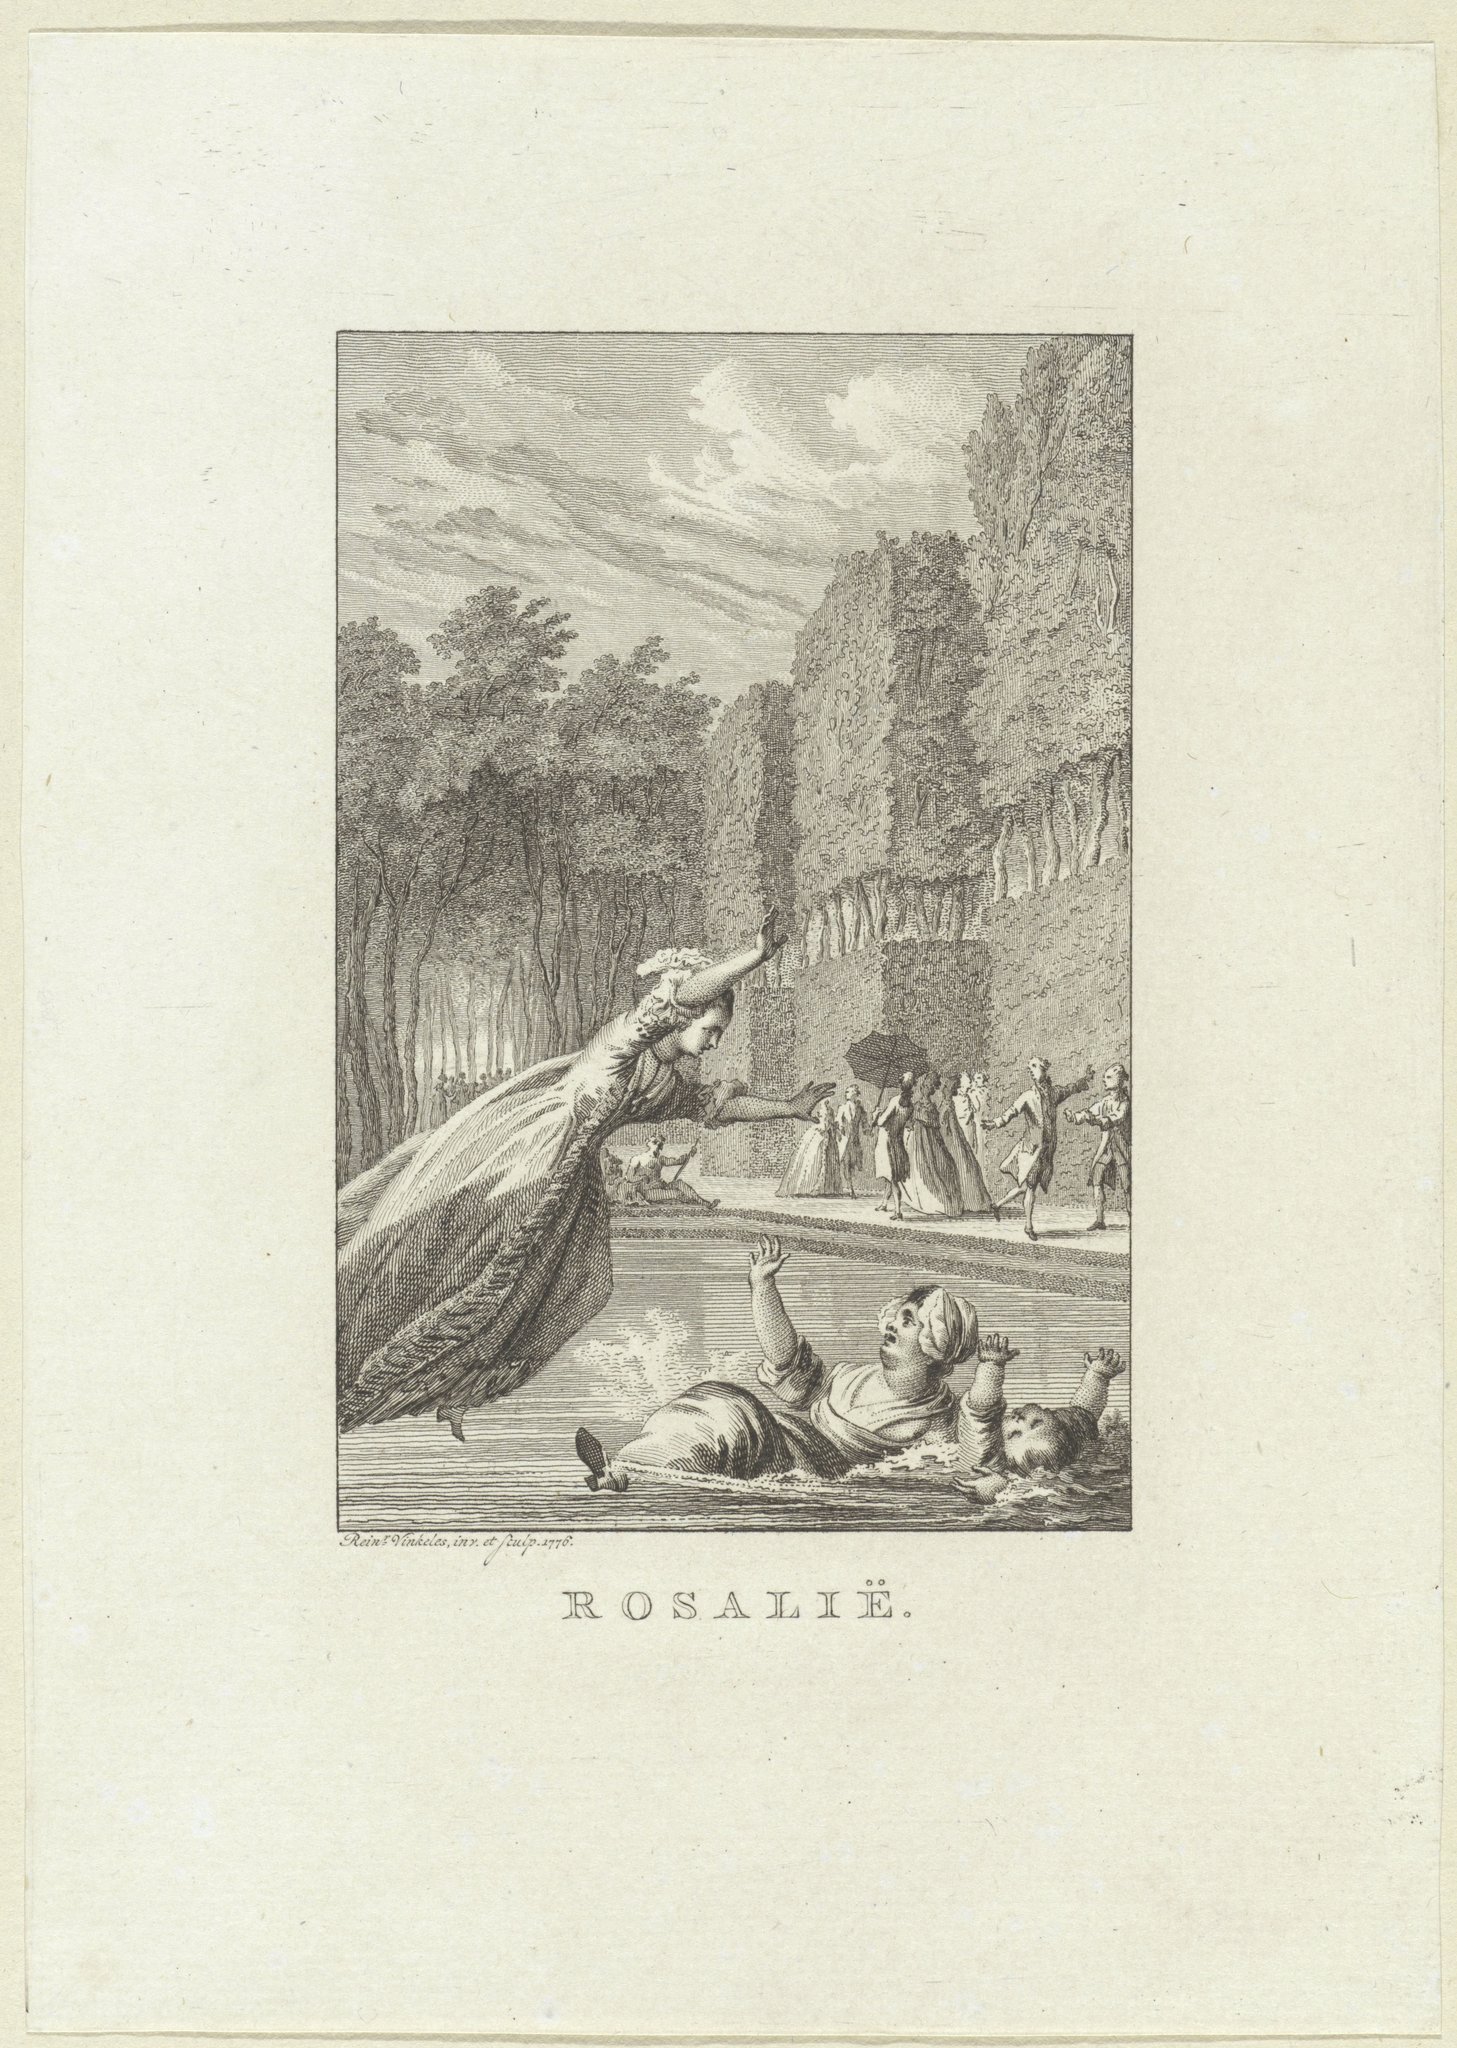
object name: print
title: Dame schiet een vrouw en kind te hulp in het water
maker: reinier vinkeles (i)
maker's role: draughtsman, print maker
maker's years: 1741-1816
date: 1776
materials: paper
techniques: engraving, etching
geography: amsterdam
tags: park, umbrella, saving a person from drowning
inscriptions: collector's mark: Lugt 240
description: Deze prent is ook gebruikt als illustratie bij het verhaal 'Rosalië' voor: Baculard d'Arnaud, F.T.M. de. Zedelijke verhaalen, deel 1. Amsterdam: A. Mens Jansz. en A.E. Munnikhuisen, 1776.